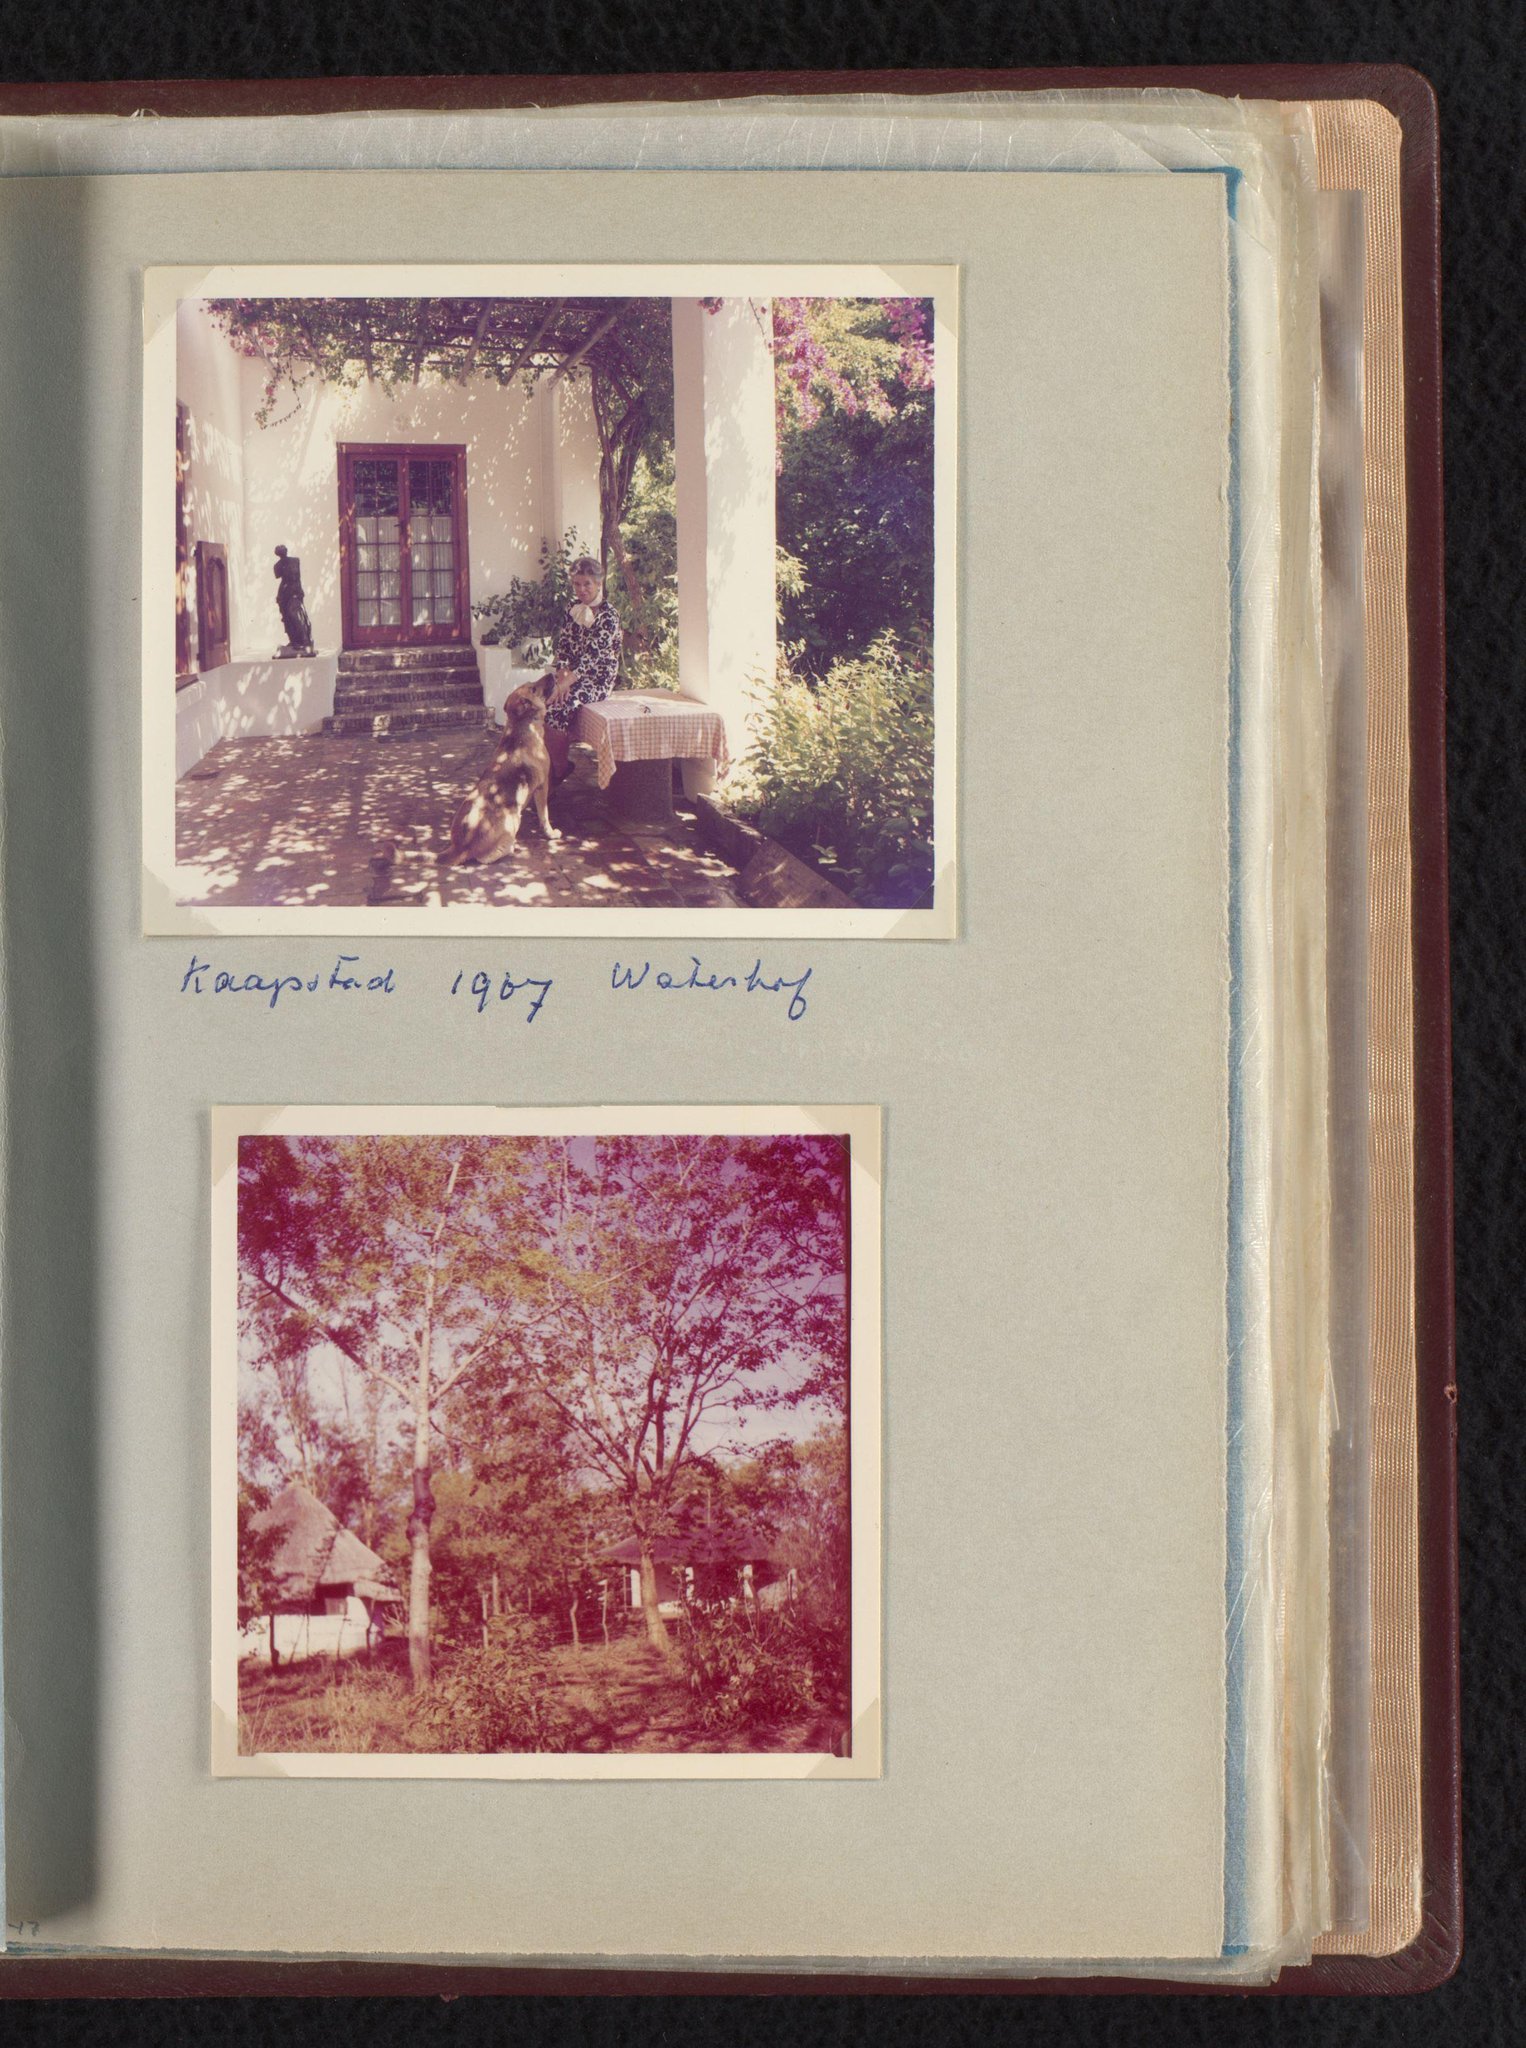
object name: album leaf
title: Onbekende vrouw met hond bij de wijngaard Waterhof in Kaapstad, en een dorpsgezicht in Zuid-Afrika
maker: willem jacob van den berg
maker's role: boer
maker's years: 1902-1983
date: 1967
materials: paper, cardboard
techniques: chromogenic print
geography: south africa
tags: vineyard, village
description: Deze foto's zijn onderdeel van een album.